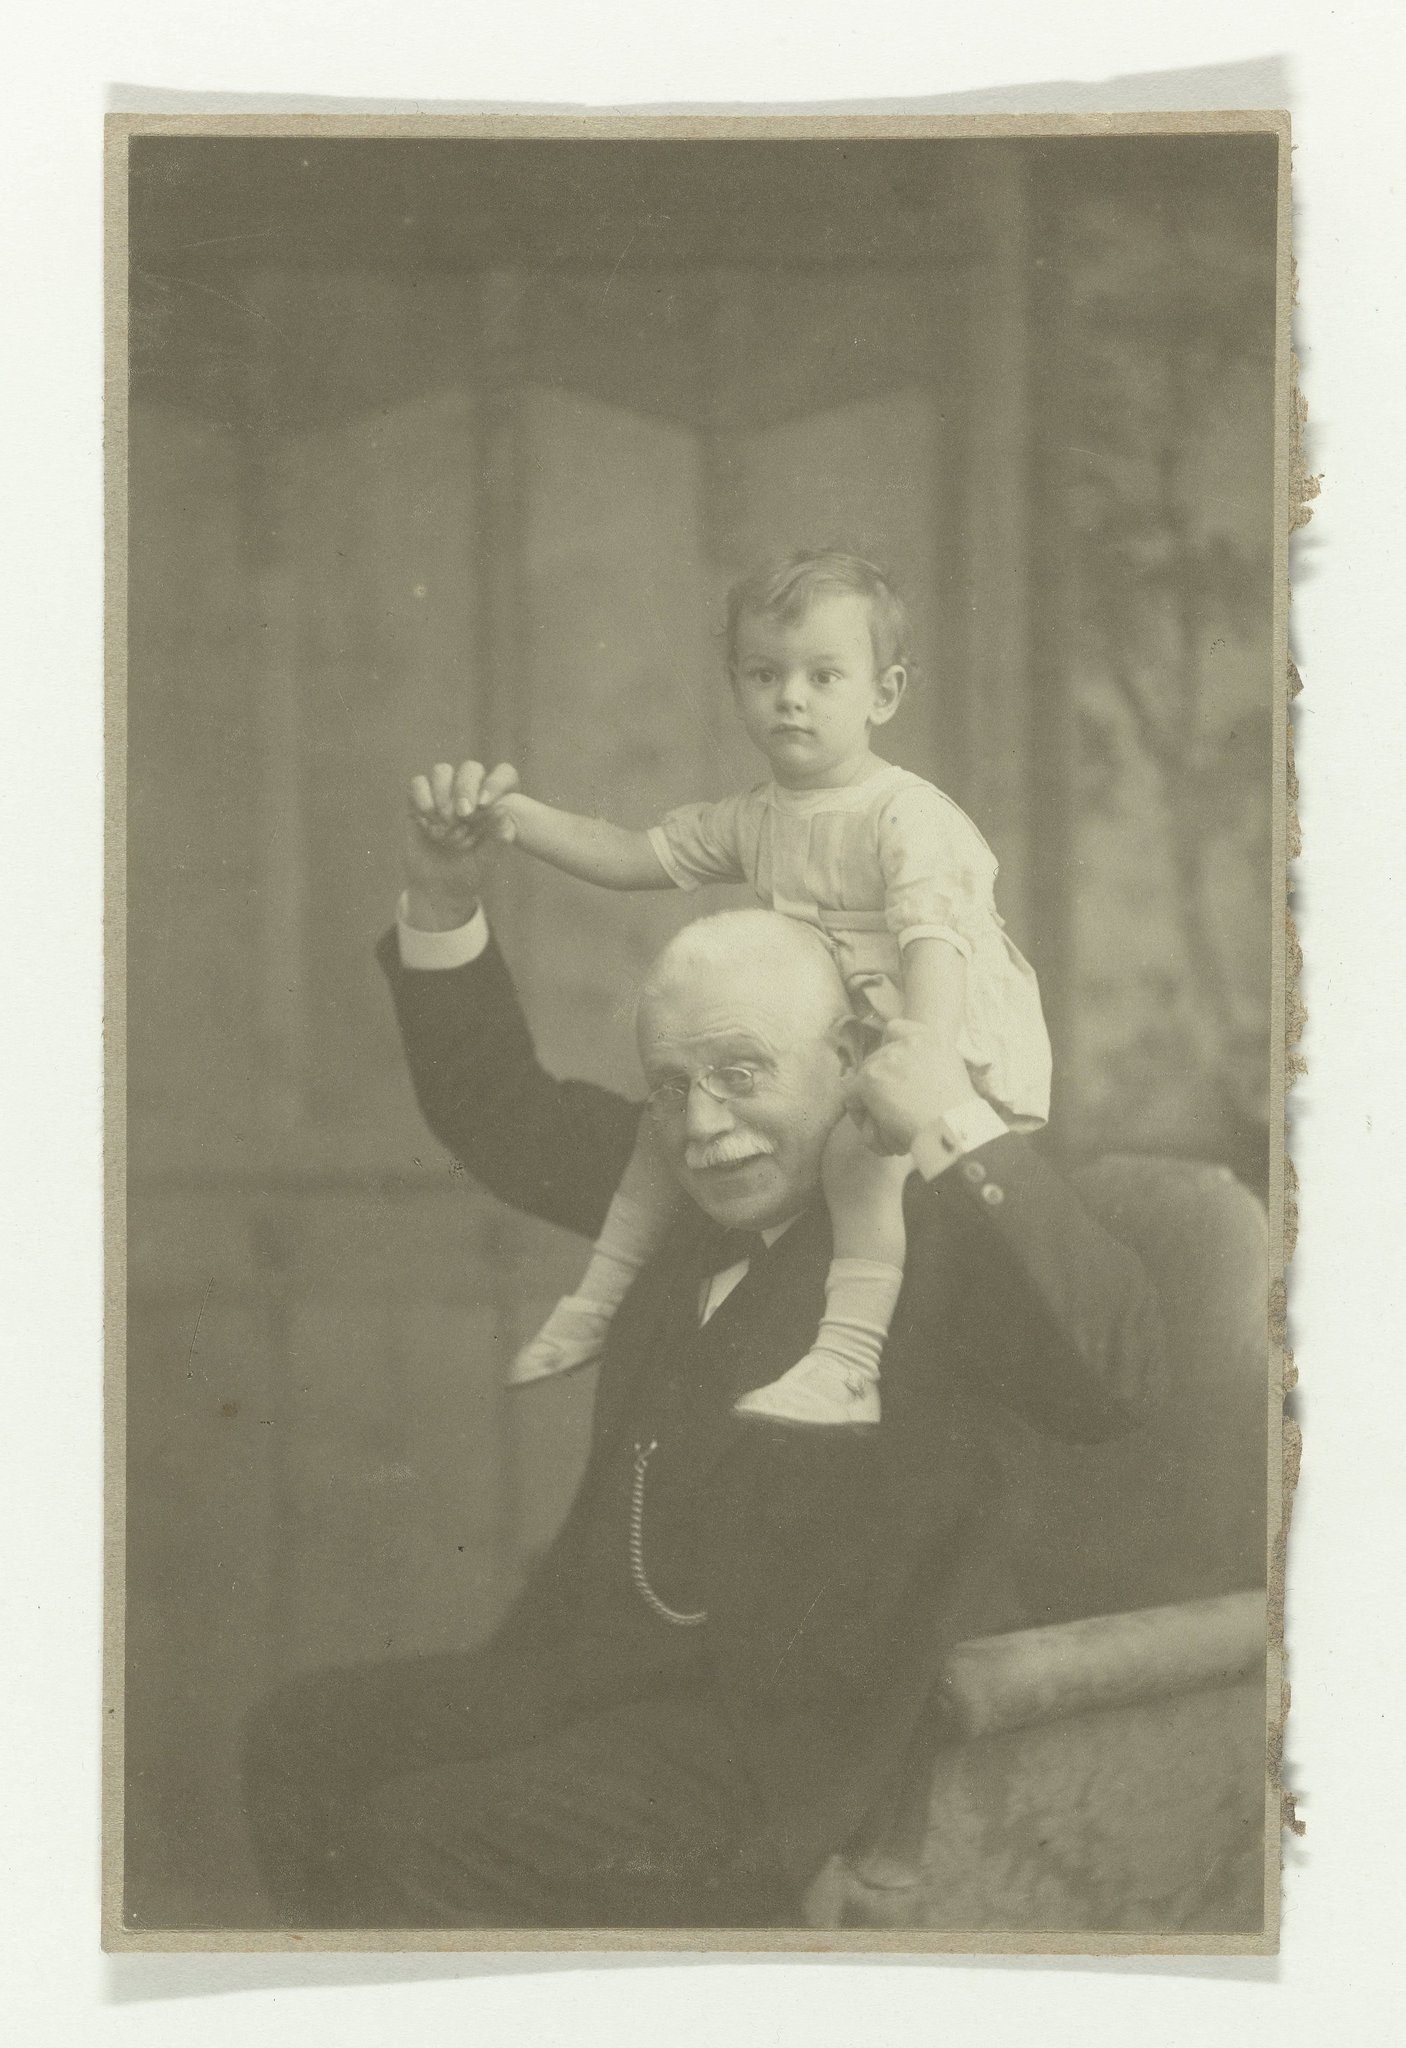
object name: photograph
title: Foto van Tonny van Renterghem, 1 jaar oud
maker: Anonymous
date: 1920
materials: photographic support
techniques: photography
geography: netherlands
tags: amsterdam, tonny van renterghem, netherlands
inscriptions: inscription: ‘TvRenterghem op de schouder van zijn grootvader, de psychiater Dr A.W. van Renterghem - 1920’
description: Bruin getinte foto van Tonny van Renterghem als kind van 1 jaar oud. Zit op de schouders van een oudere man, zijn grootvader, met snor en lorghet. De man houdt de handen van het kind vast, hij zit in een feauteuil.